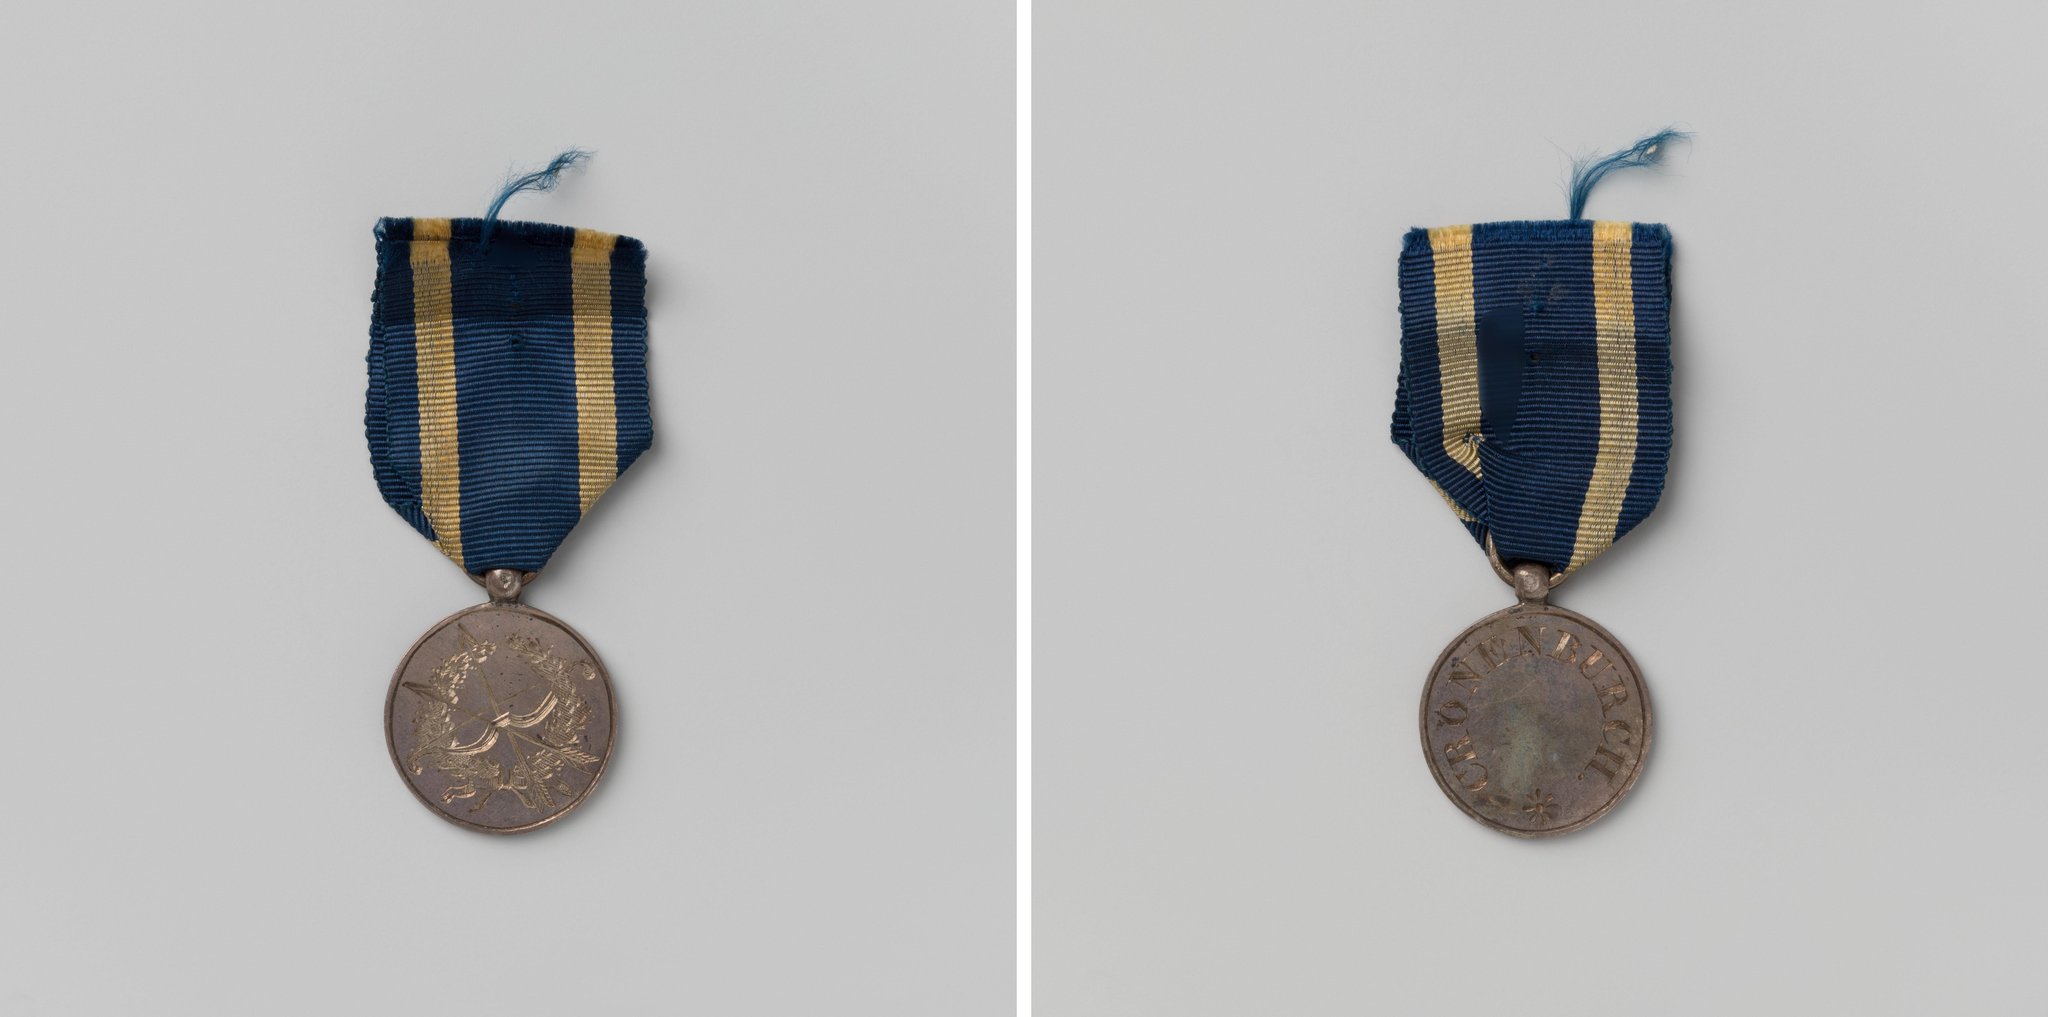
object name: marksman medal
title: Cronenburch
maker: Anonymous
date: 1800-1875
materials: silver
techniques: engraving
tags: meerdonck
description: Cronenburch. Zilveren penning aan draagoog, draagring en lint met vijf verticale banen in blauw en geel van ongelijke breedte. Voorzijde: twee gekruiste pijlen op boog binnen bladerkrans. Keerzijde: leeg veld binnen omschrift